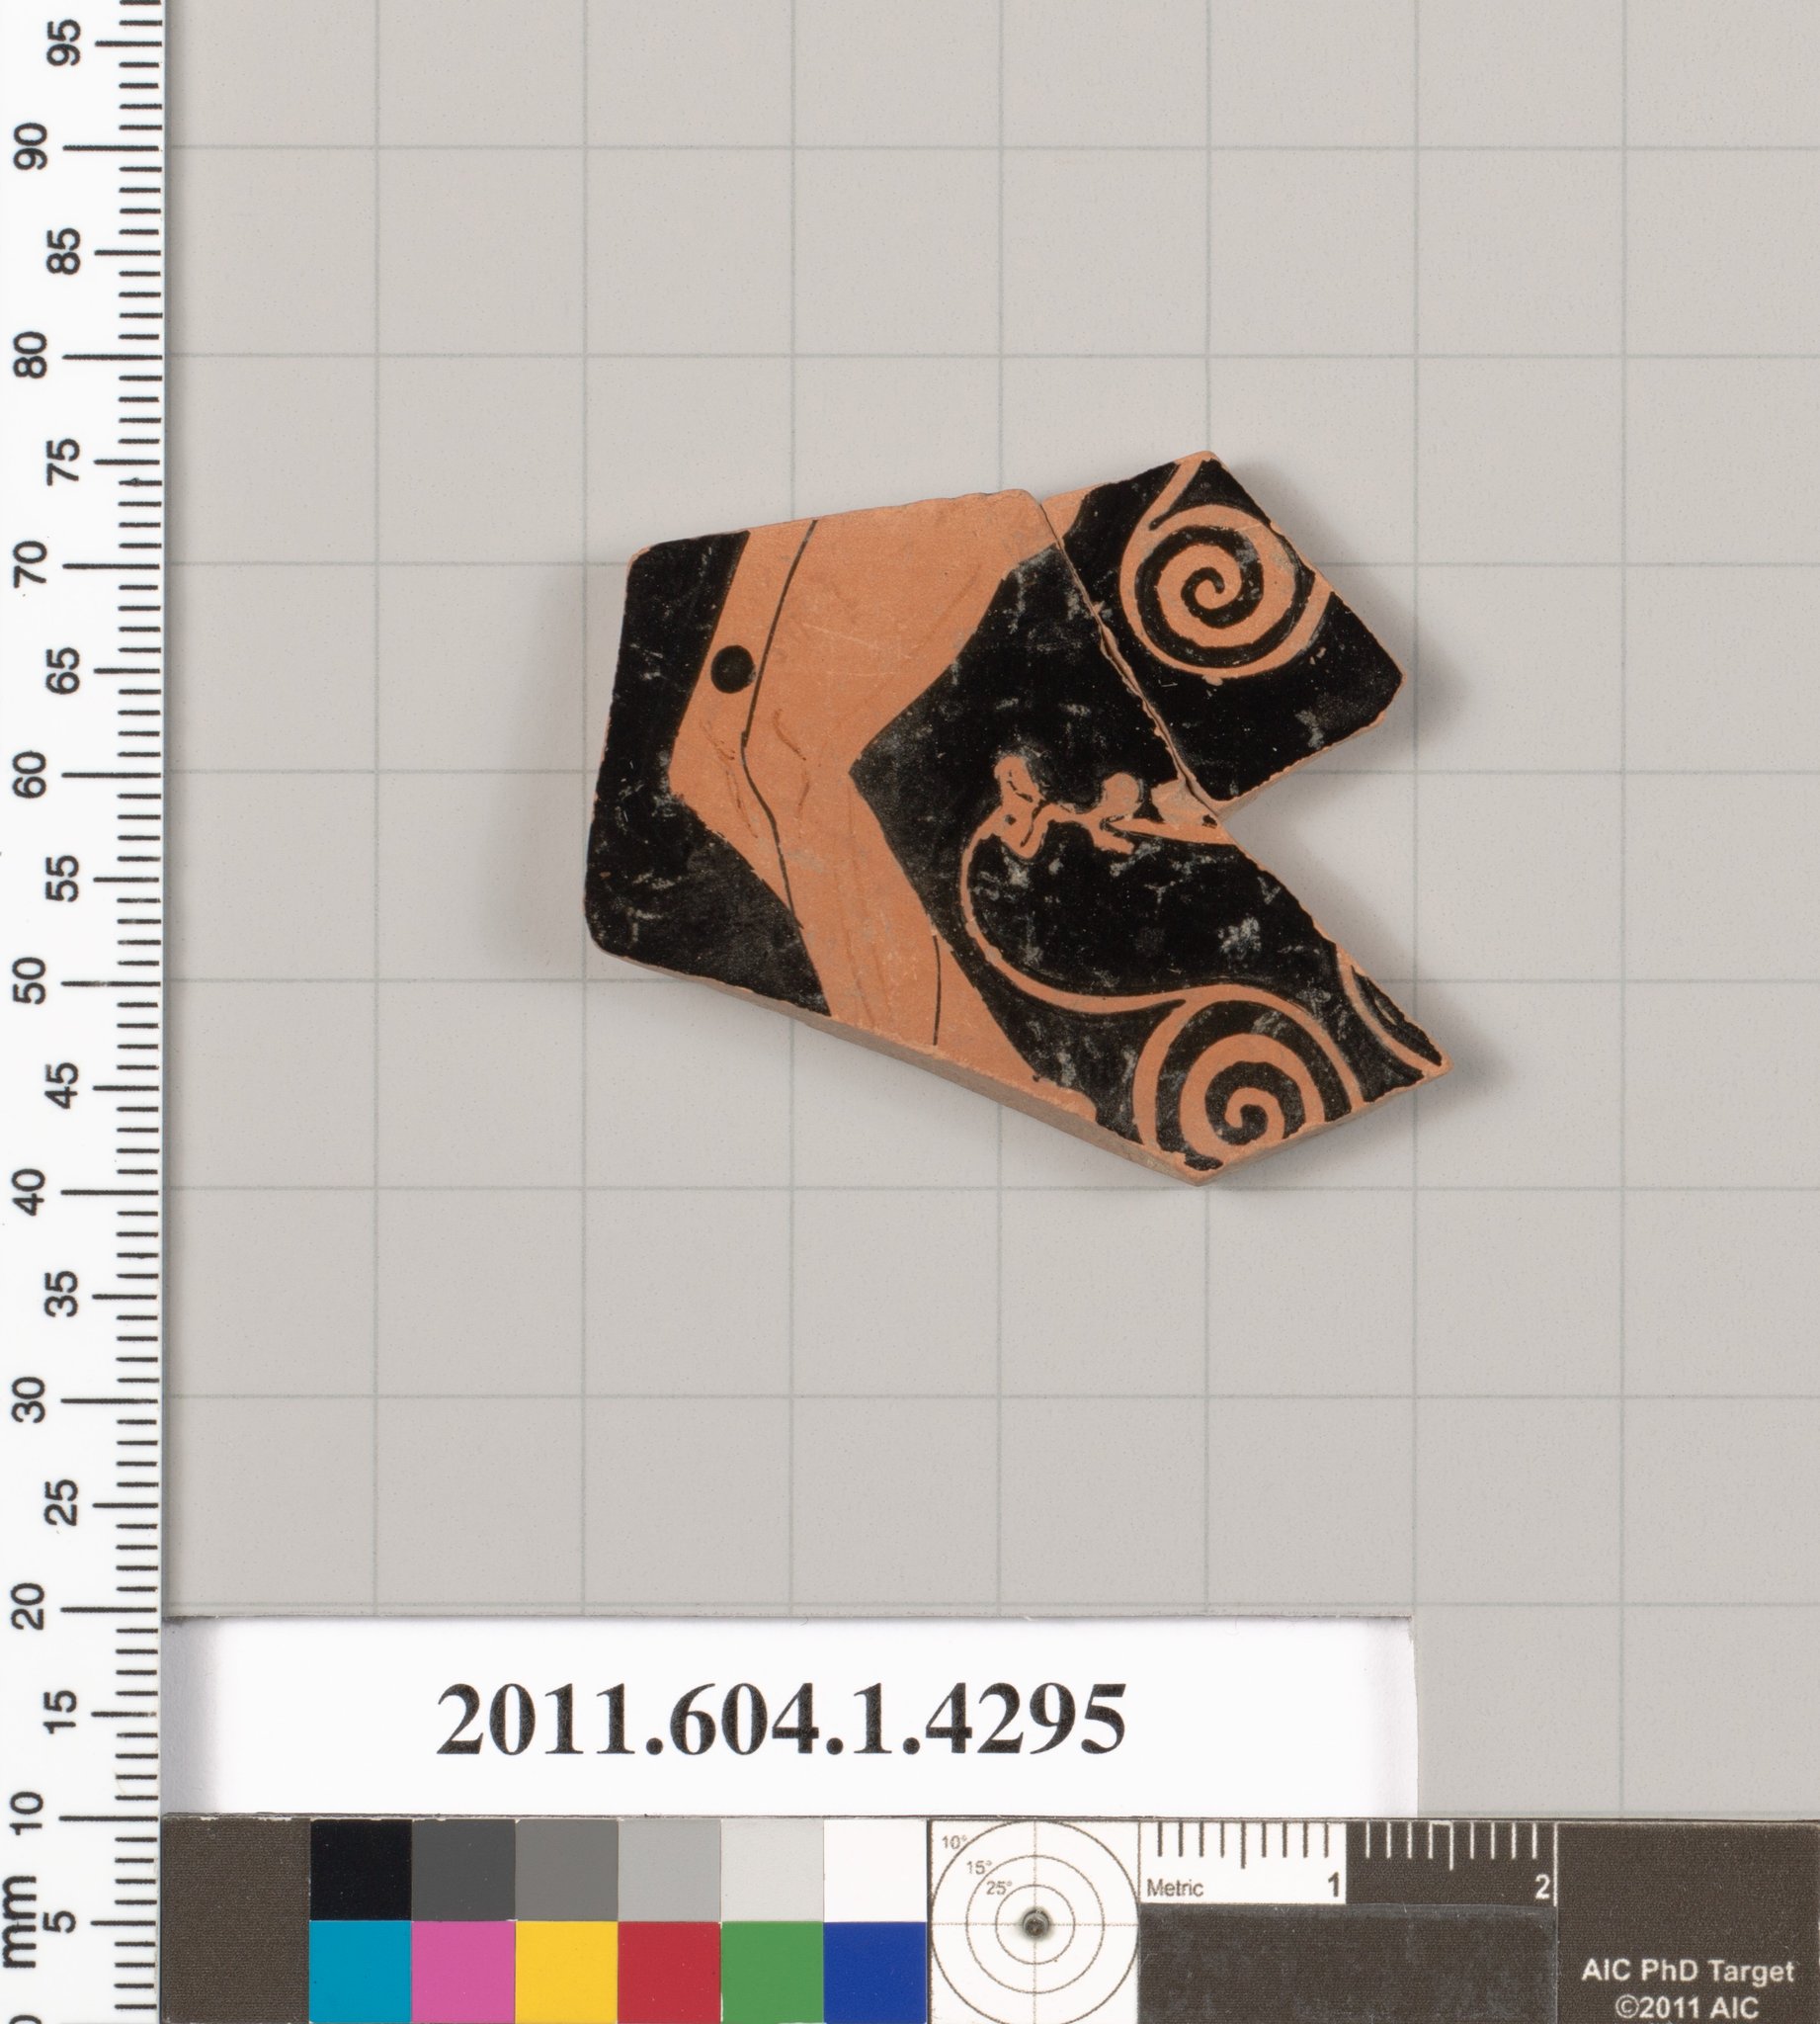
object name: kylix fragment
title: Terracotta fragment of a kylix (drinking cup)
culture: greek, attic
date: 490-470 BCE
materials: terracotta